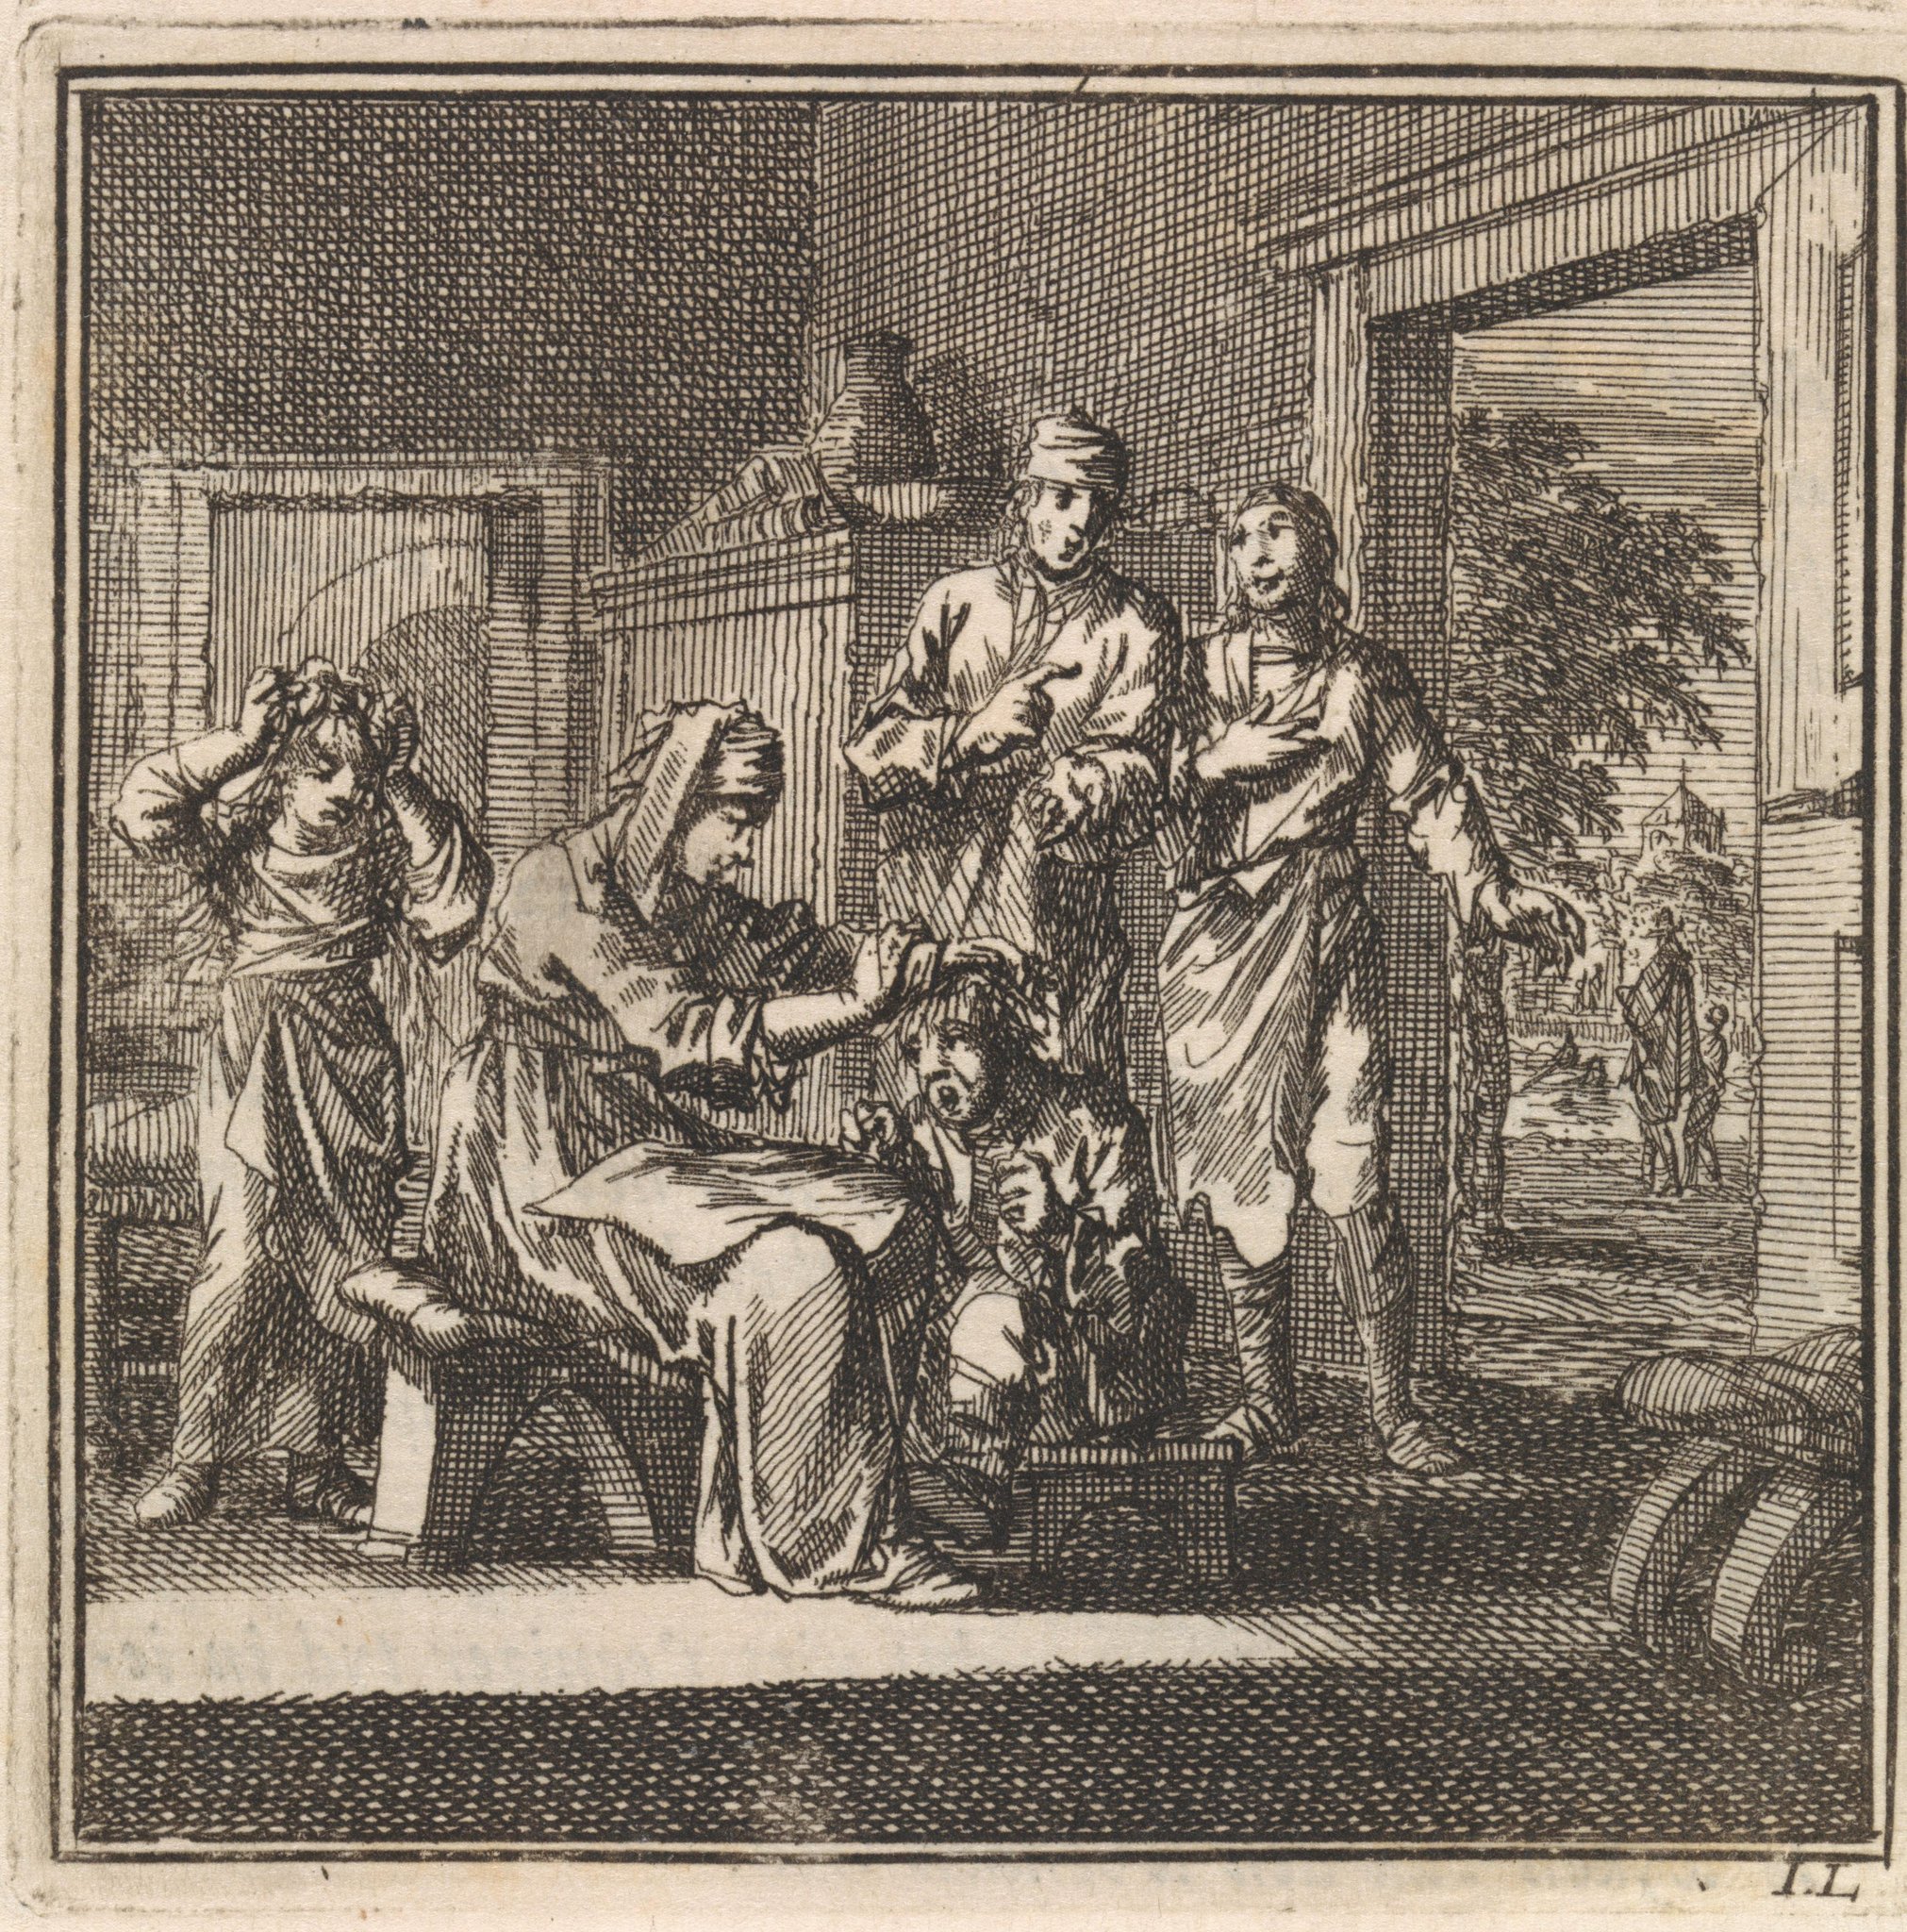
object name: print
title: De Kam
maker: jan luyken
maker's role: draughtsman, print maker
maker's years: 1649-1712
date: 1711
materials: paper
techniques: etching, letterpress printing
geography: amsterdam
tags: comb, brush and other tools (care of the hair), hygienic care of children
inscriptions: collector's mark: Lugt 2228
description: Illustratie voor: Luyken, Jan. De Bykorf des Gemoeds. Amsterdam: Pieter Arentsz. II (wed.) en Cornelis van der Sys, 1711, p. 134.